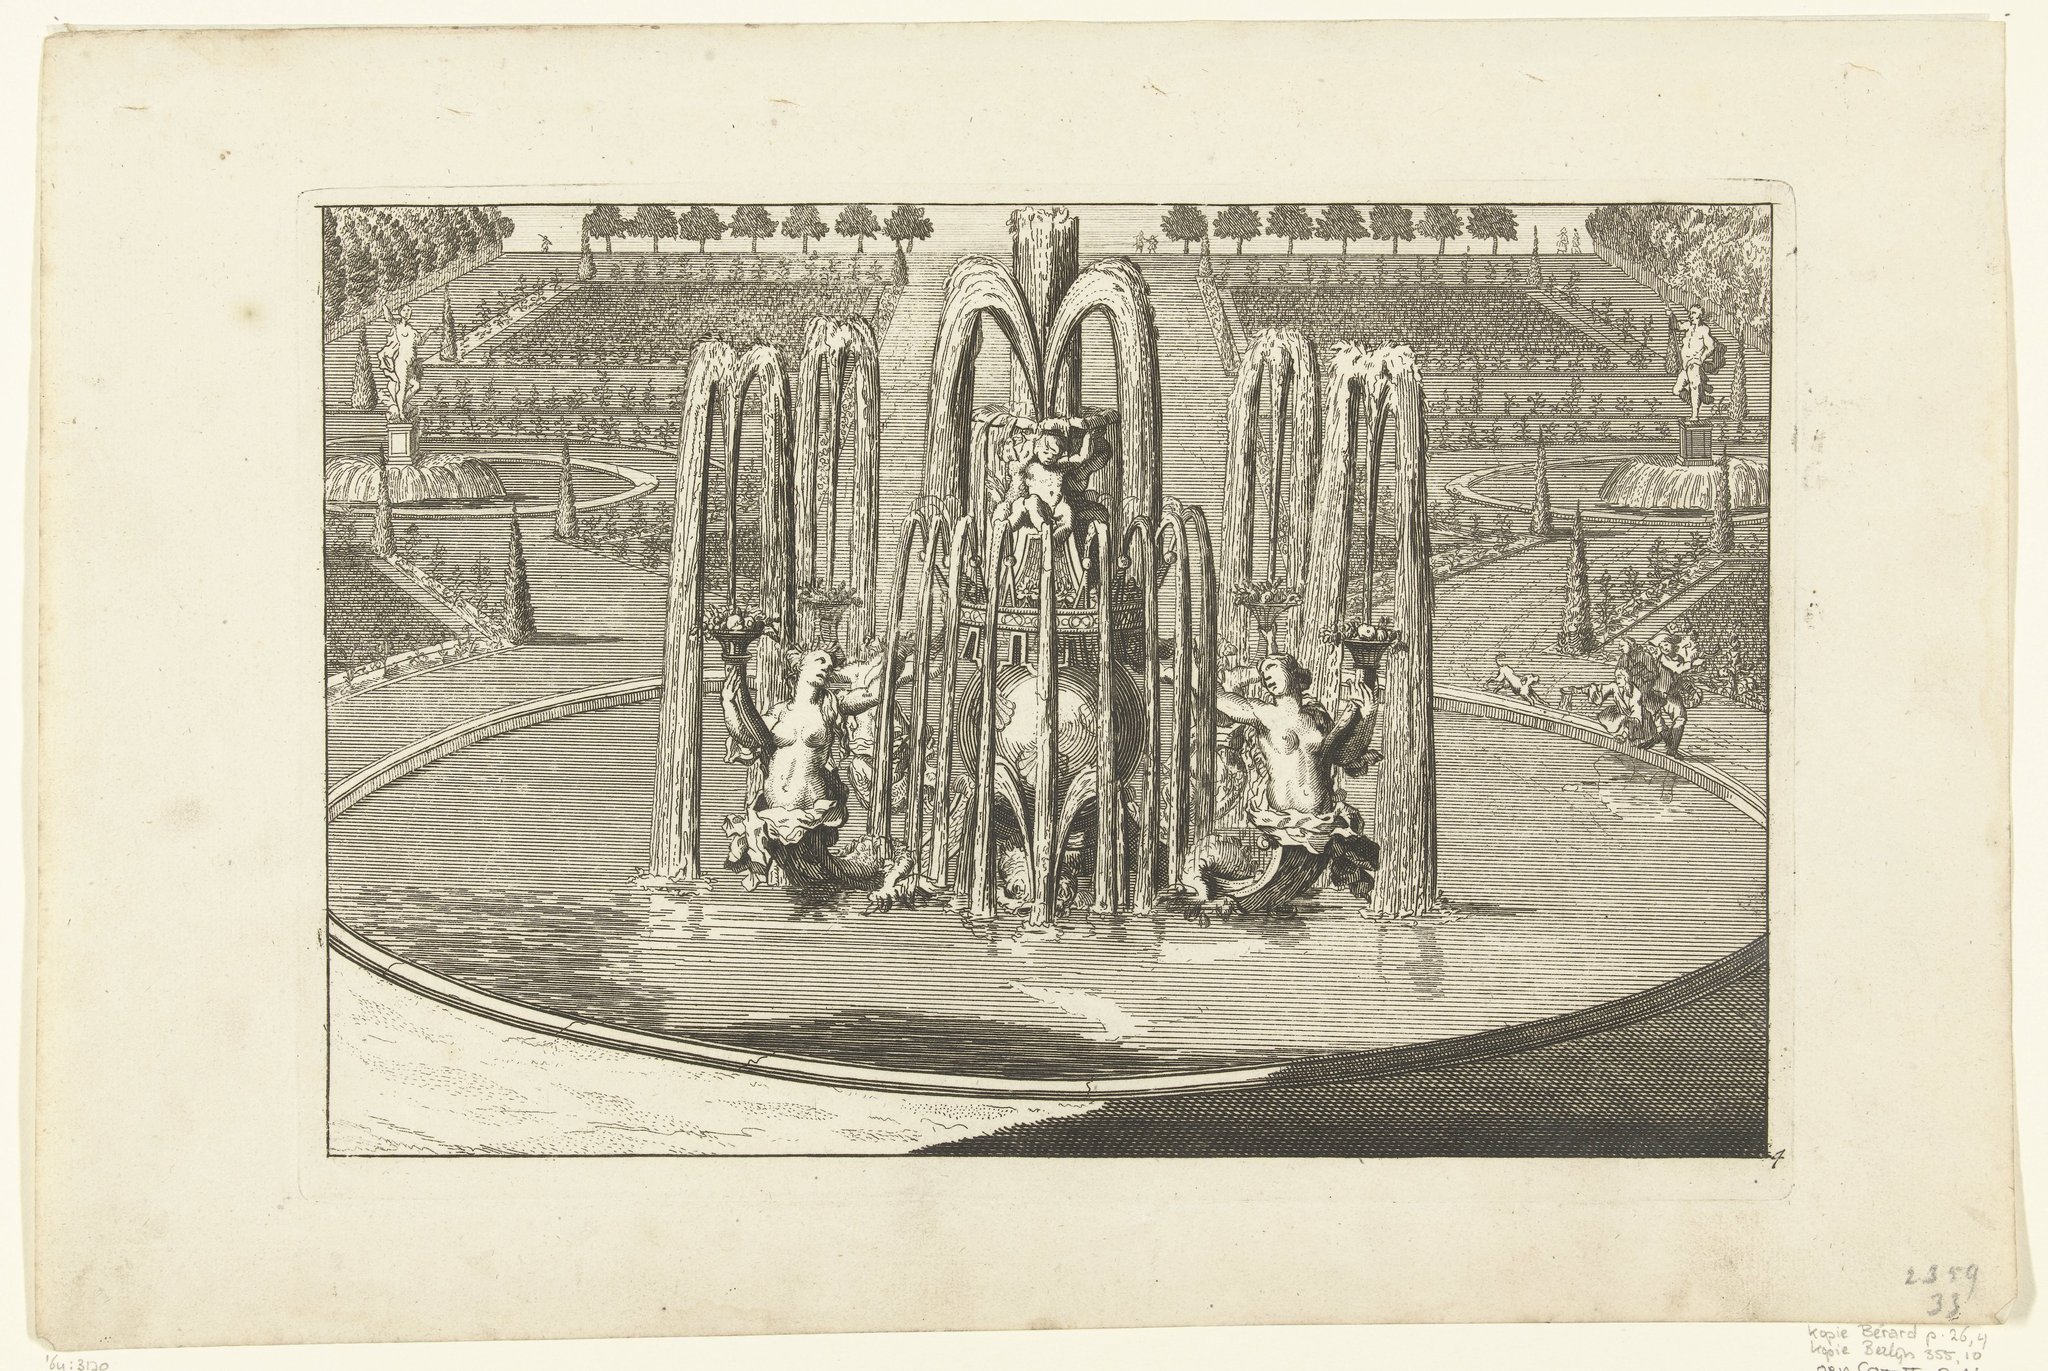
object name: print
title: Nova Fontium Delineatio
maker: Anonymous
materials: paper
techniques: etching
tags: garden fountain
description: Op de achtergrond kleinere bassins en parterres. Tegenzijdige kopie naar blad uit serie Liure de fontaines uitgegeven door Daniel Marot.